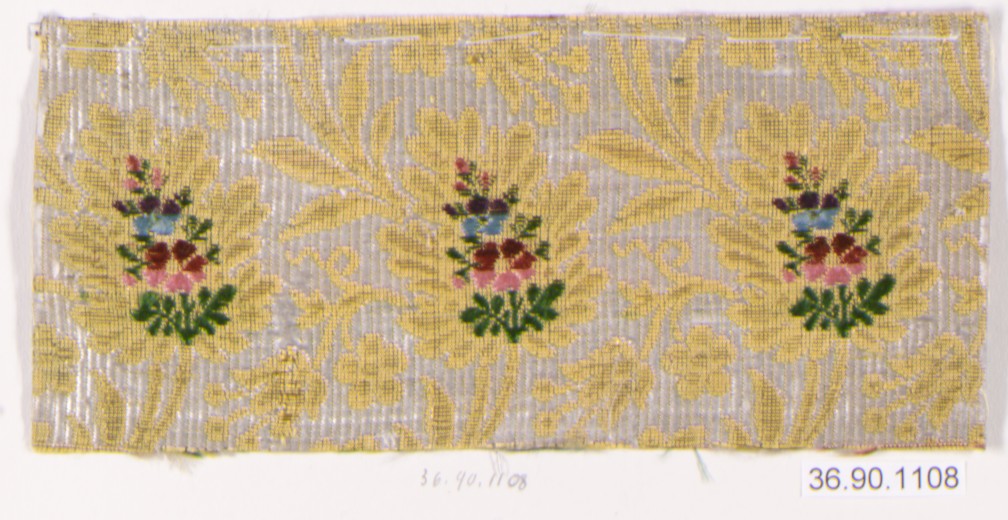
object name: sample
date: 1701-1900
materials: metal thread, silk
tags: flowers